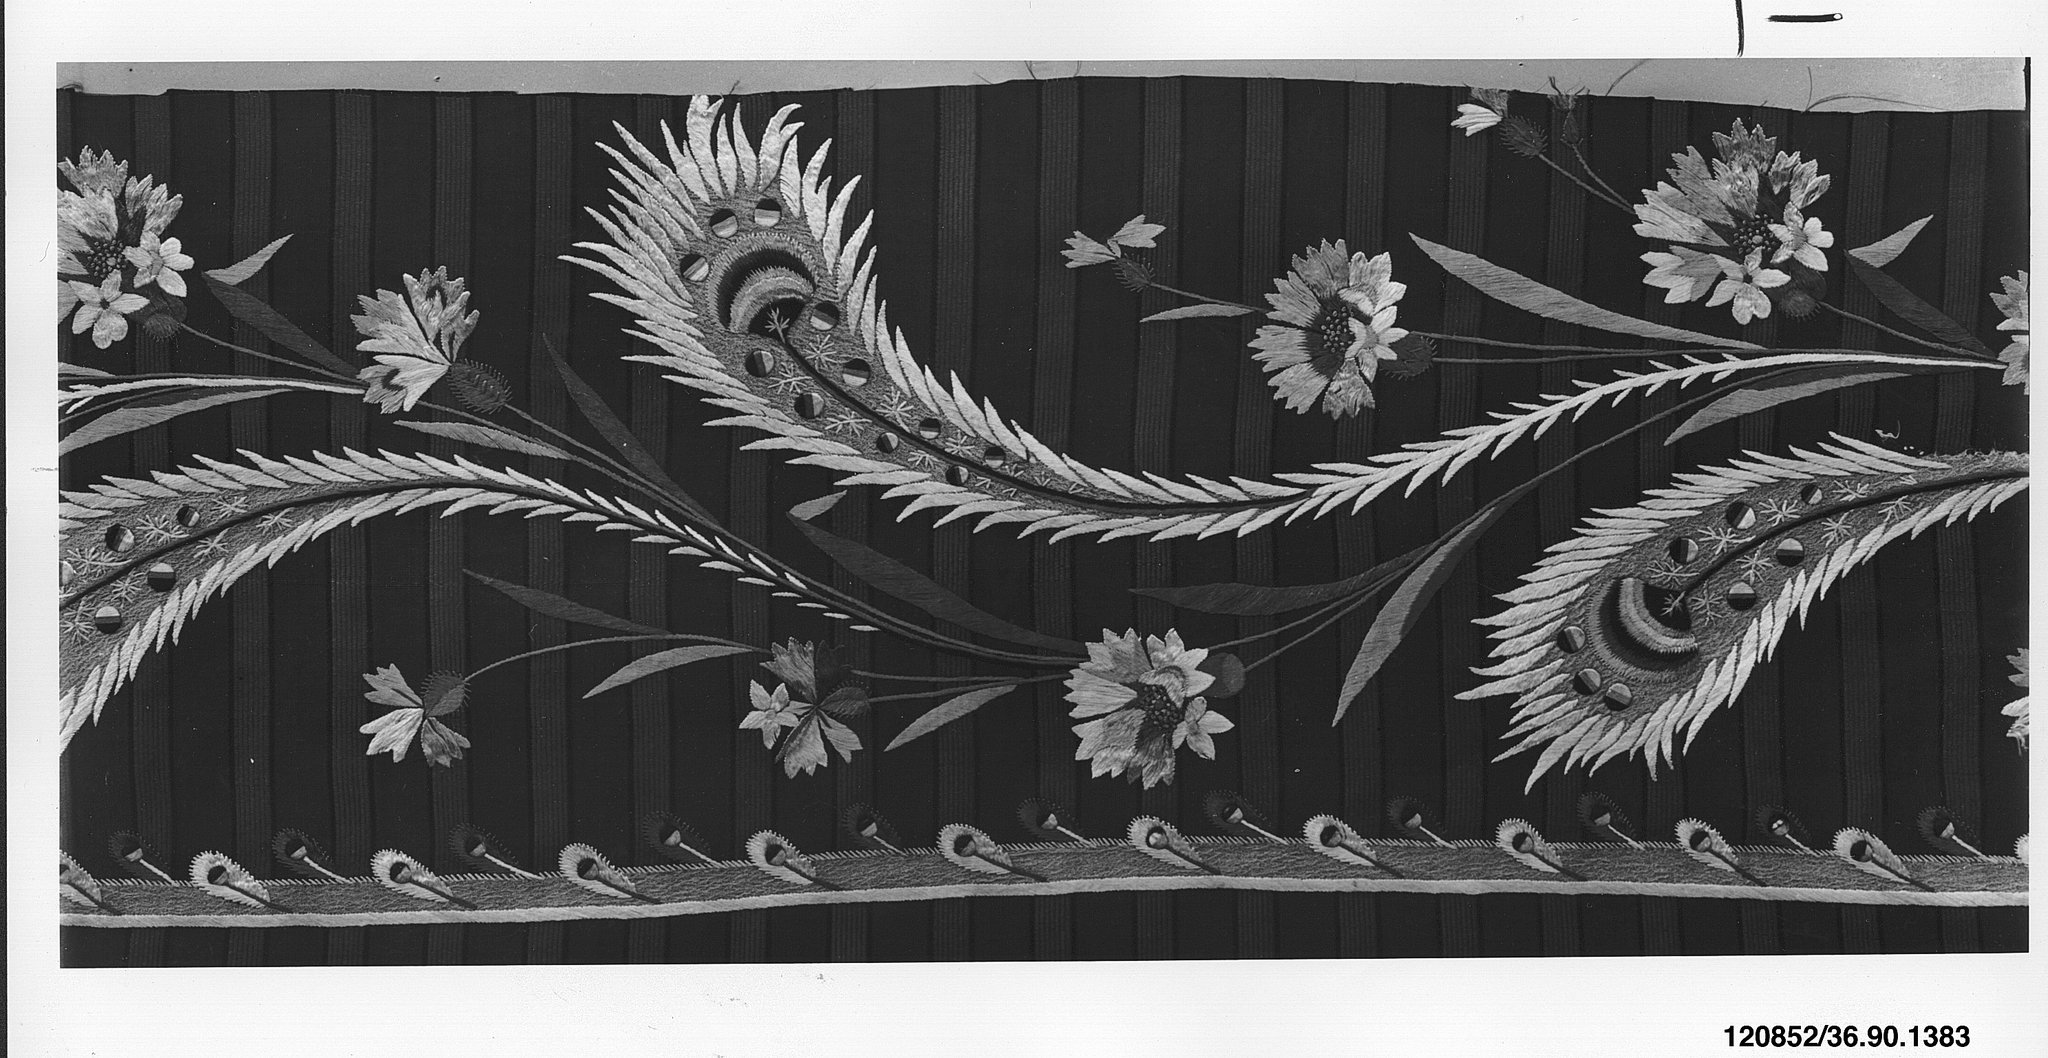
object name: border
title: Dress border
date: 1801-1833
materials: silk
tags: flowers,leaves